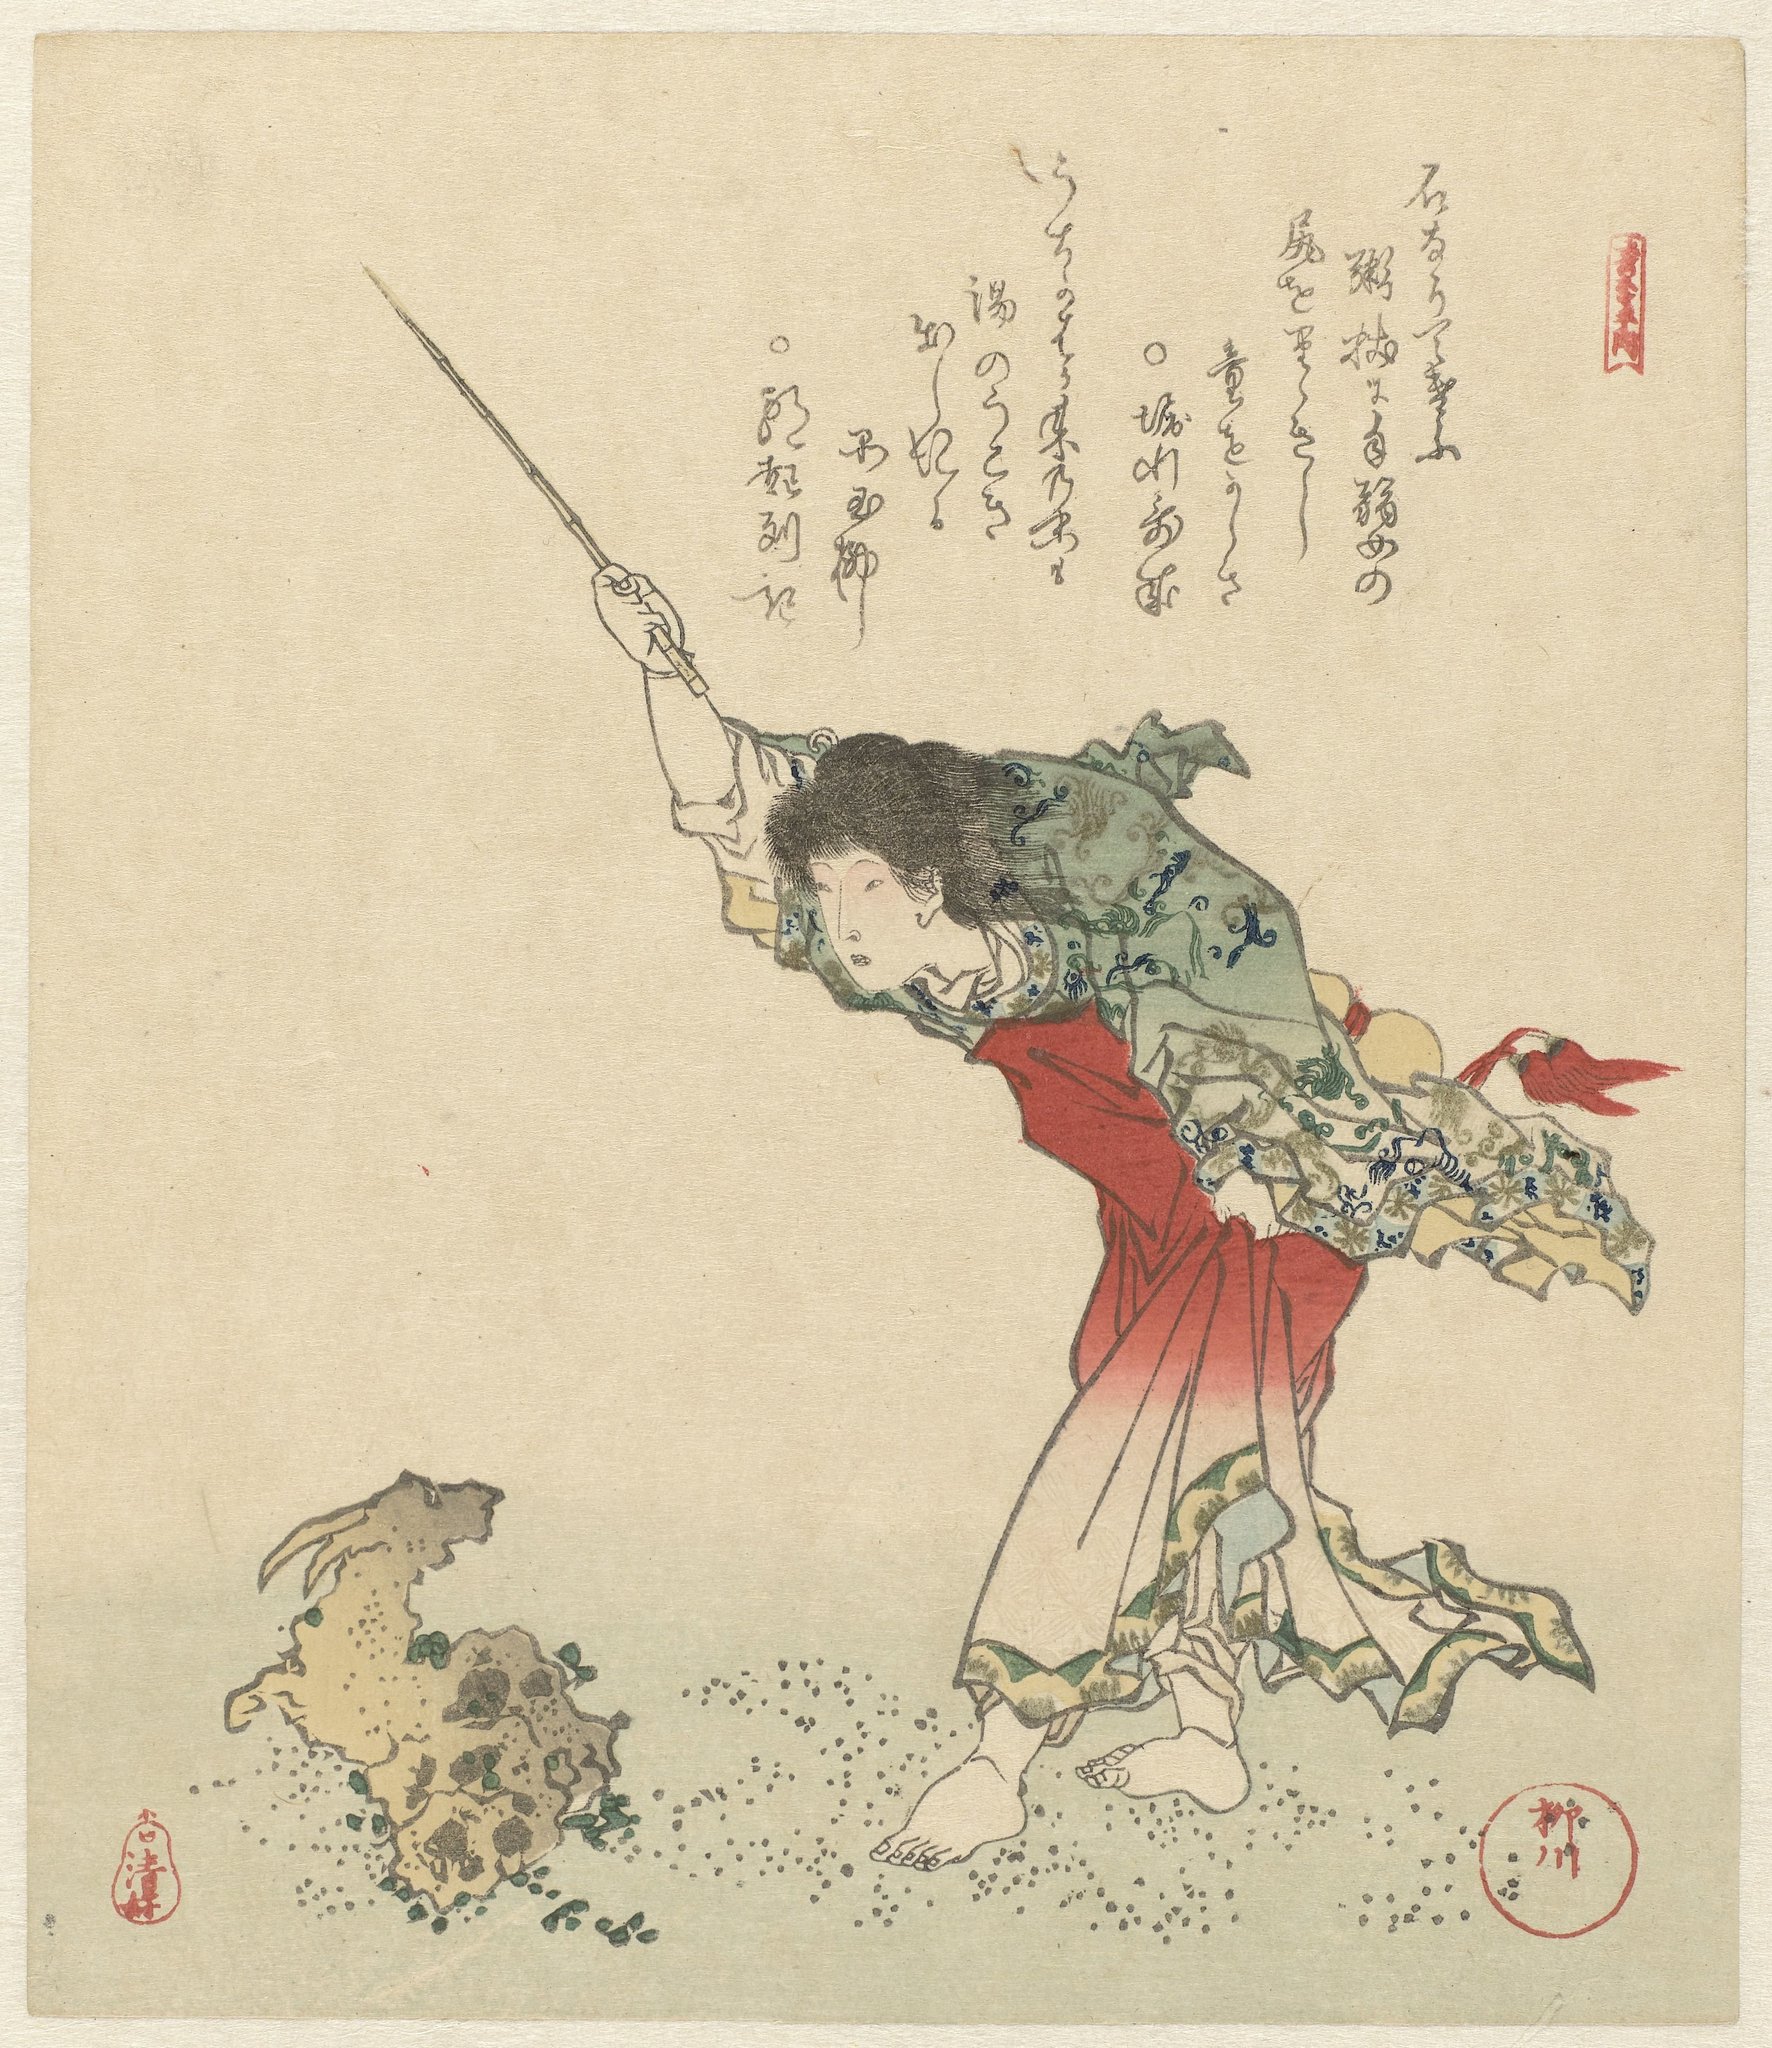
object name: surimono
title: Vijf prenten over langlevendheid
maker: shigenobu (ii)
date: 1890-1900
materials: paper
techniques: blind stamped, woodcut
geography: japan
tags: conceptions and ideas visualized ~ traditional chinese religions, metamorphoses of (fabulous) animals, goat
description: Een surimono is een luxe uitgevoerde prent waarop beeld met één of meerdere gedichten gecombineerd is. Bij het drukken van een surimono werd vaak gebruik gemaakt van dikker papier, blinddruk en metaal pigmenten, zoals koper- en zilverpoeder. De prenten werden vaak in opdracht van dichters gemaakt en als exclusief geschenk aan vrienden en relaties gegeven.